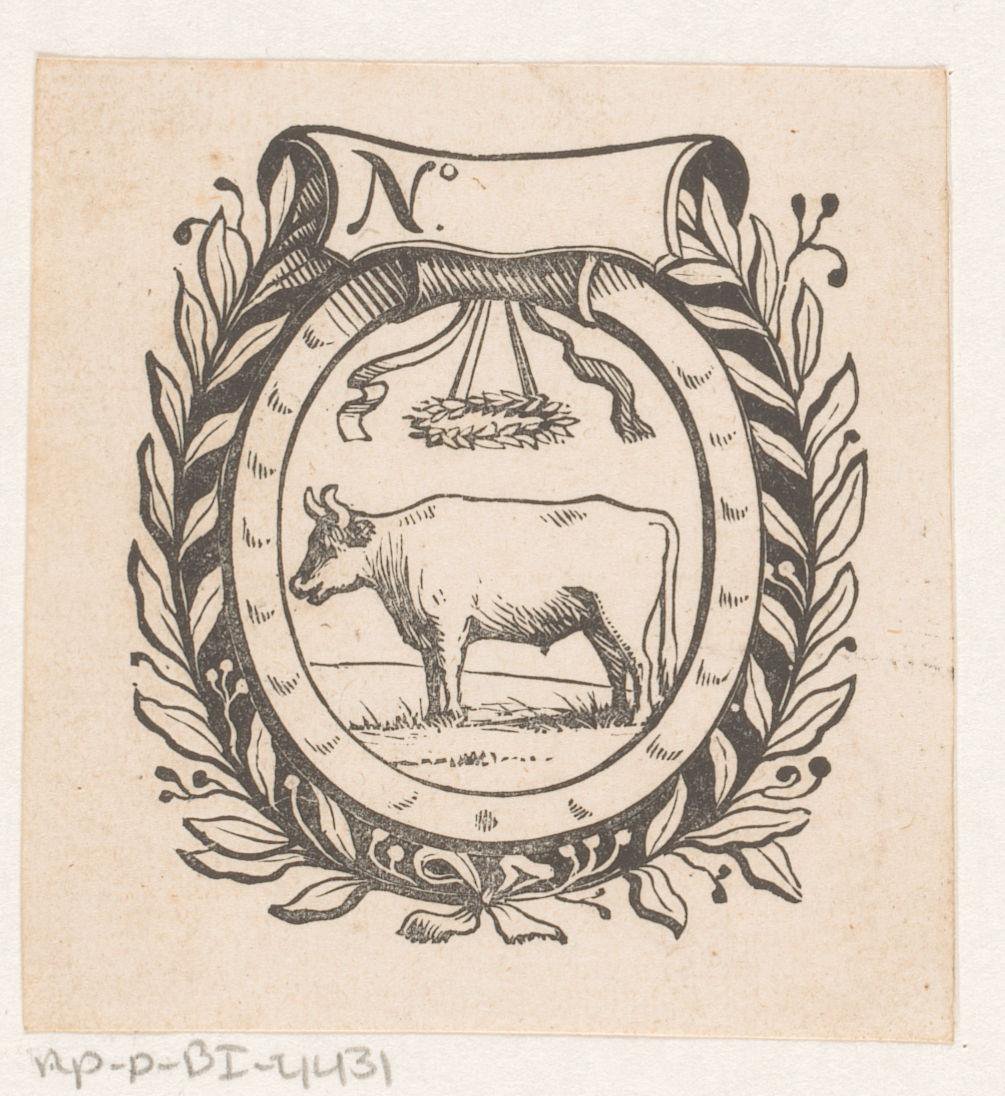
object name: print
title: Vignet met een os en een lauwerkrans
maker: Anonymous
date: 1600-1699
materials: paper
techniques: woodcut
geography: netherlands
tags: garland, wreath, ox, vignette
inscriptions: collector's mark: Lugt 240